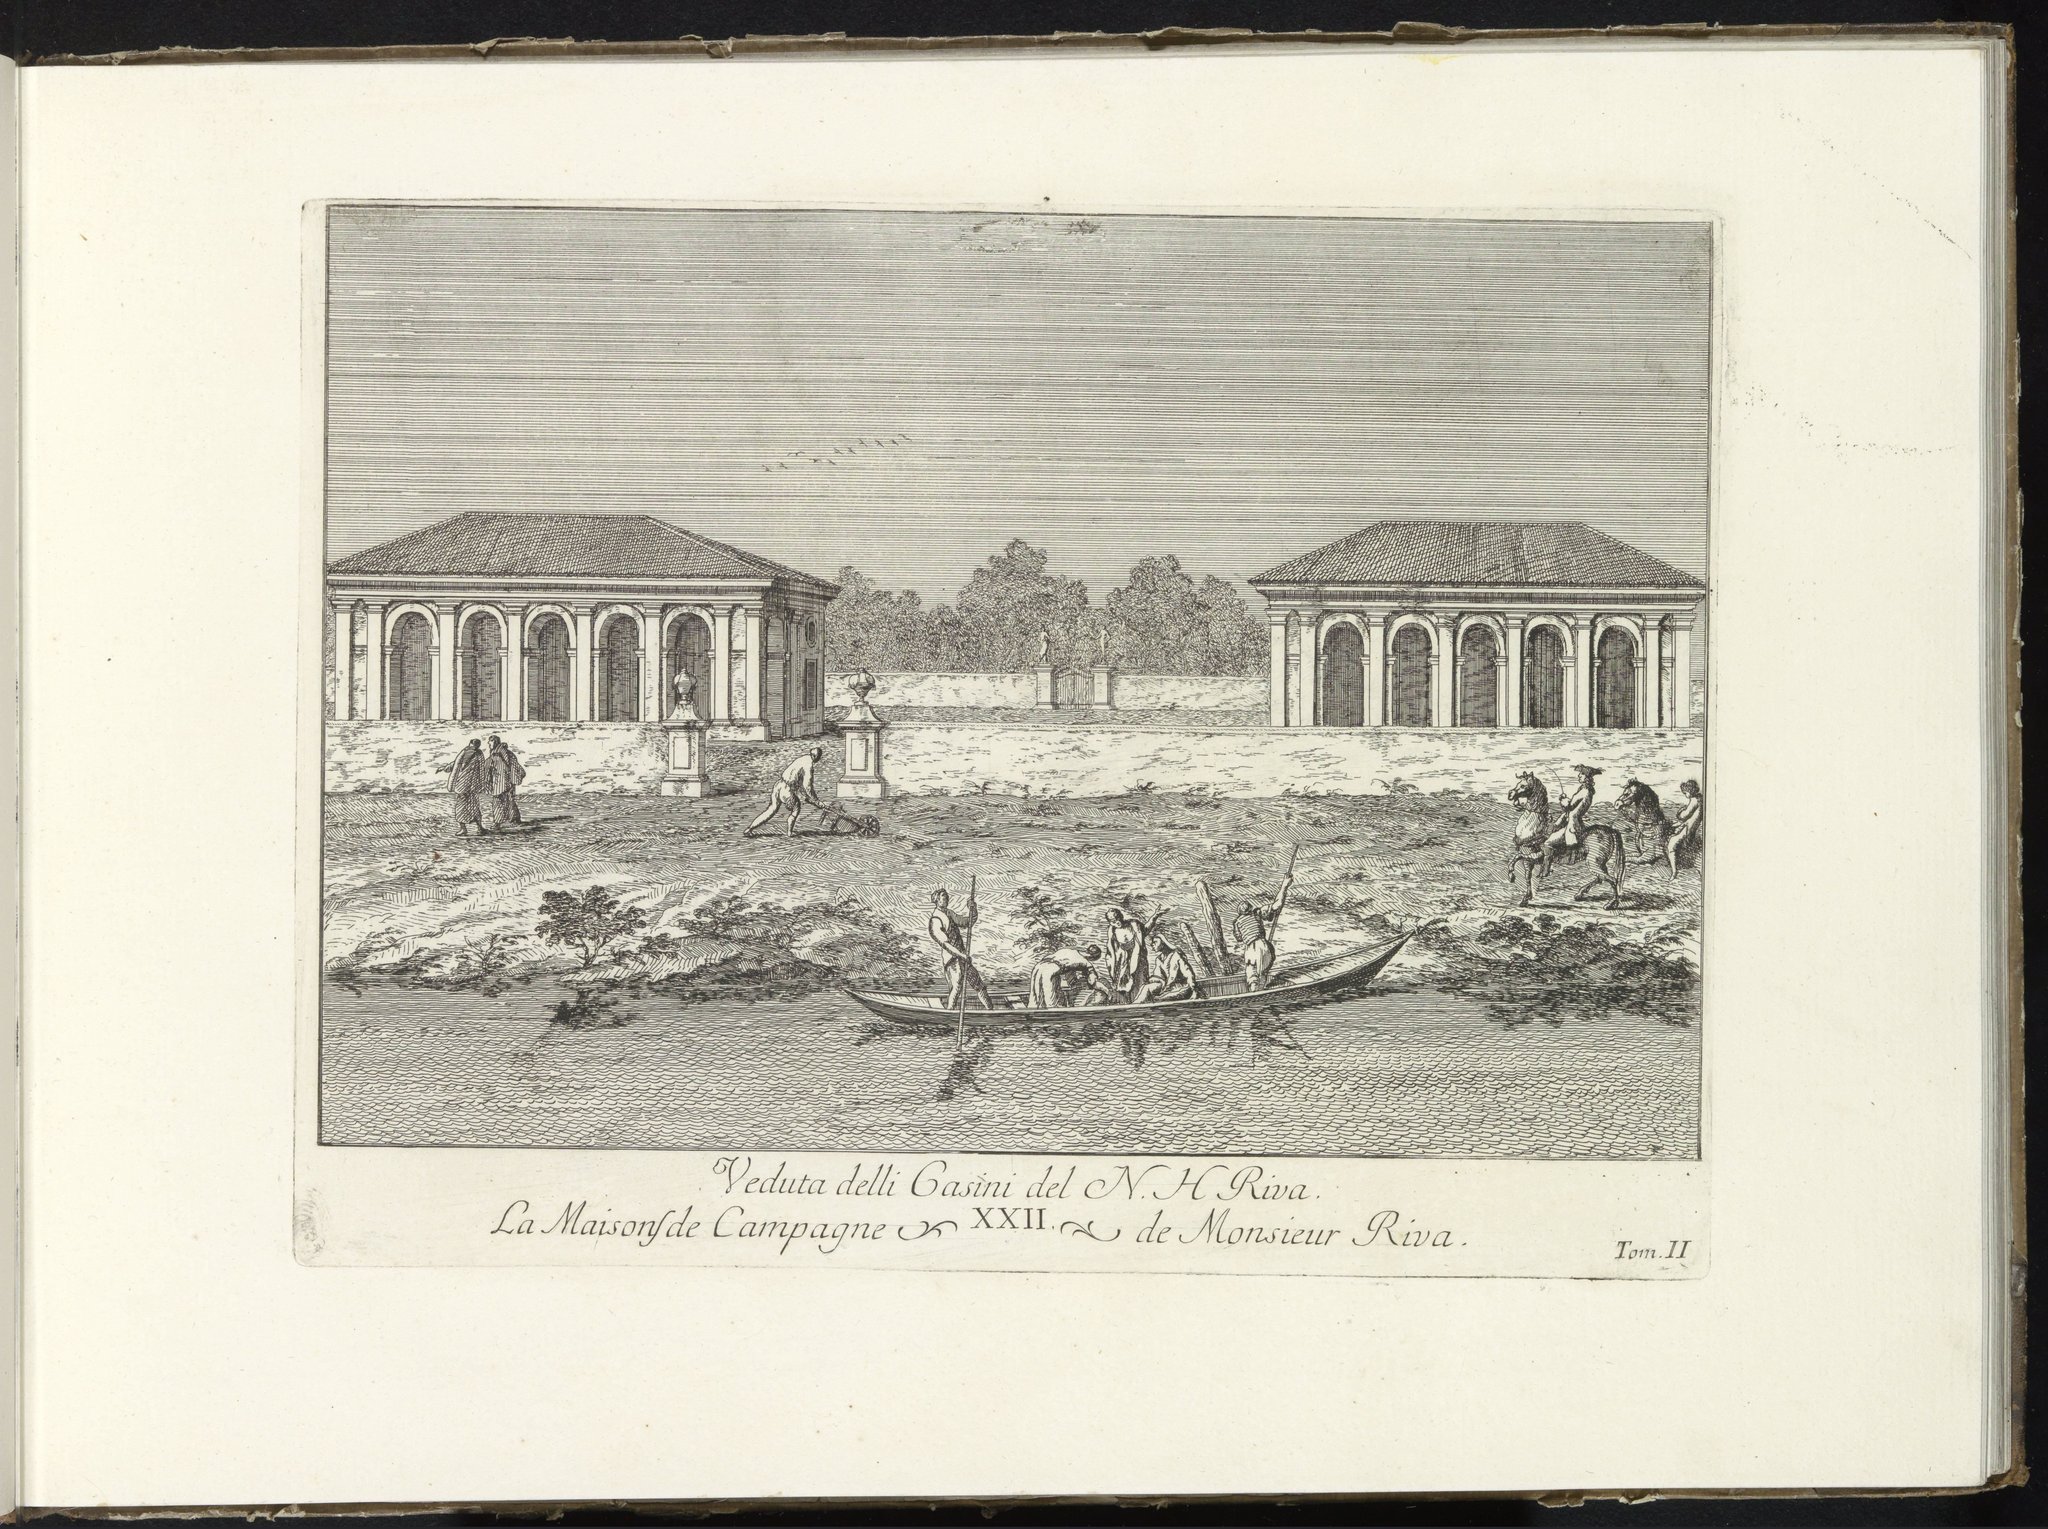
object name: print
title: Casini del N. H. Riva aan de Brenta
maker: giovanni francesco costa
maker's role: draughtsman, painter, print maker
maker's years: -1773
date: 1750-1760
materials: paper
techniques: etching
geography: italy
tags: river, hôtel, i.e. small palace in city, gondola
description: Gezicht op de Casini del N. H. Riva aan de rivier de Brenta. Op het water een gondel aan de waterkant. Rechts twee mannen te paard. Genummerd midden onder: XXII en rechtsonder: Tom: II. Deze prent maakt deel uit van een album.